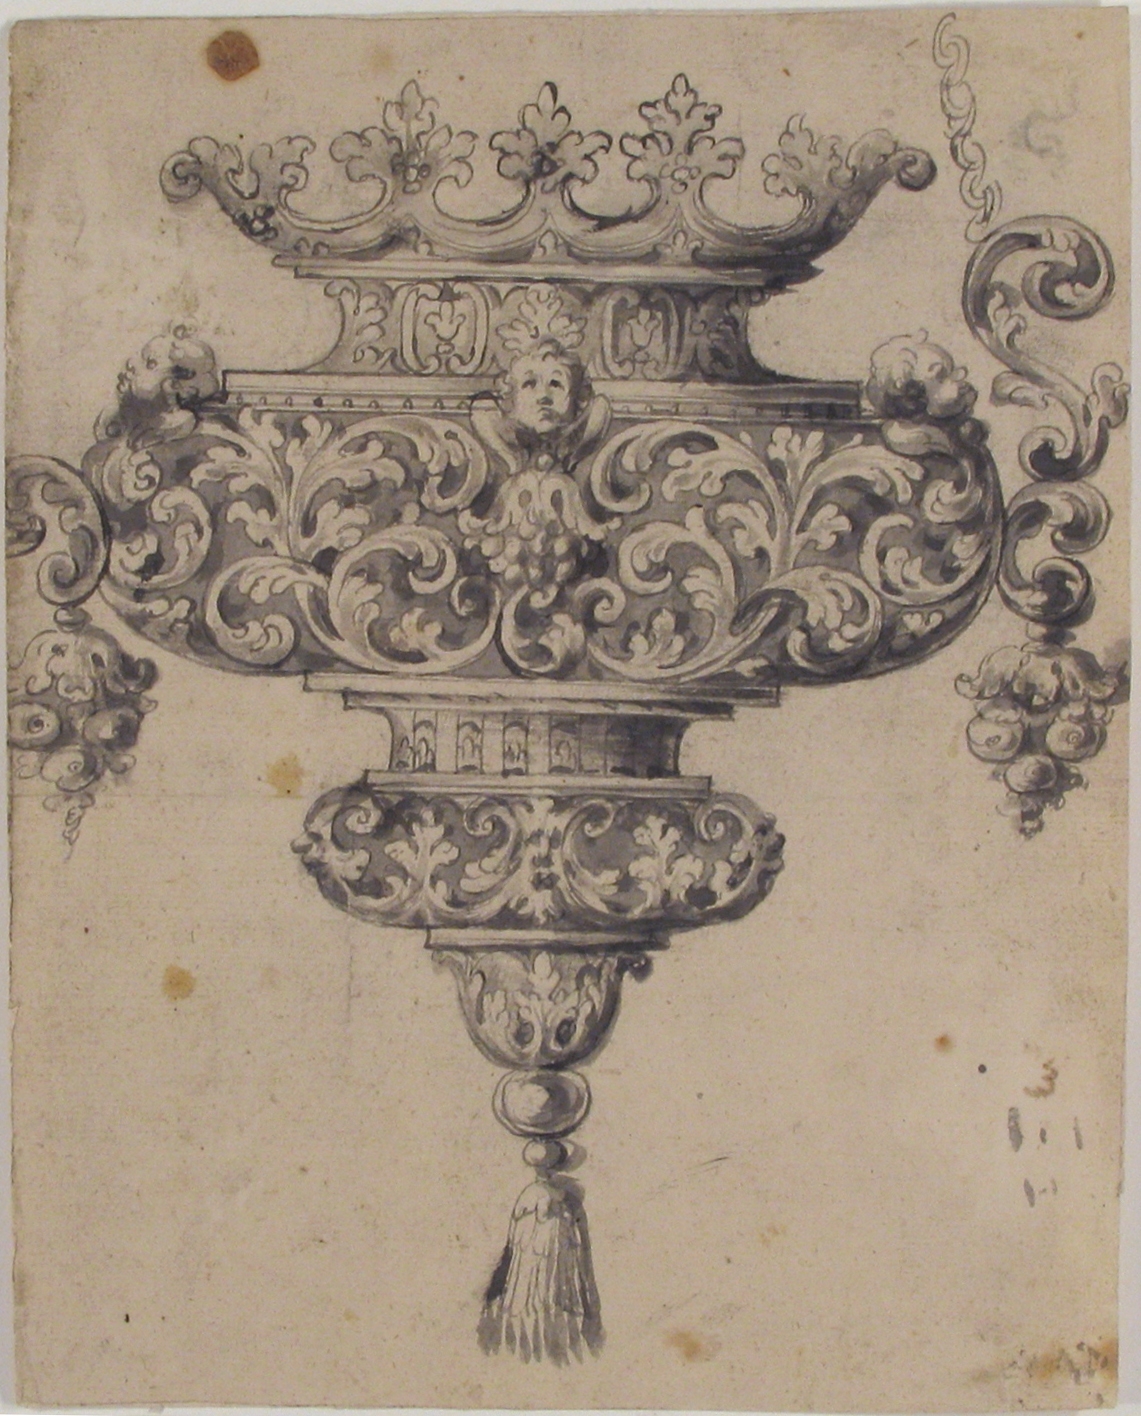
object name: drawing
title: Design for a Sconce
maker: anonymous, french, 19th century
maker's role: artist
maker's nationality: french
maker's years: 1800-1900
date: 1801-1900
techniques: brush, wash